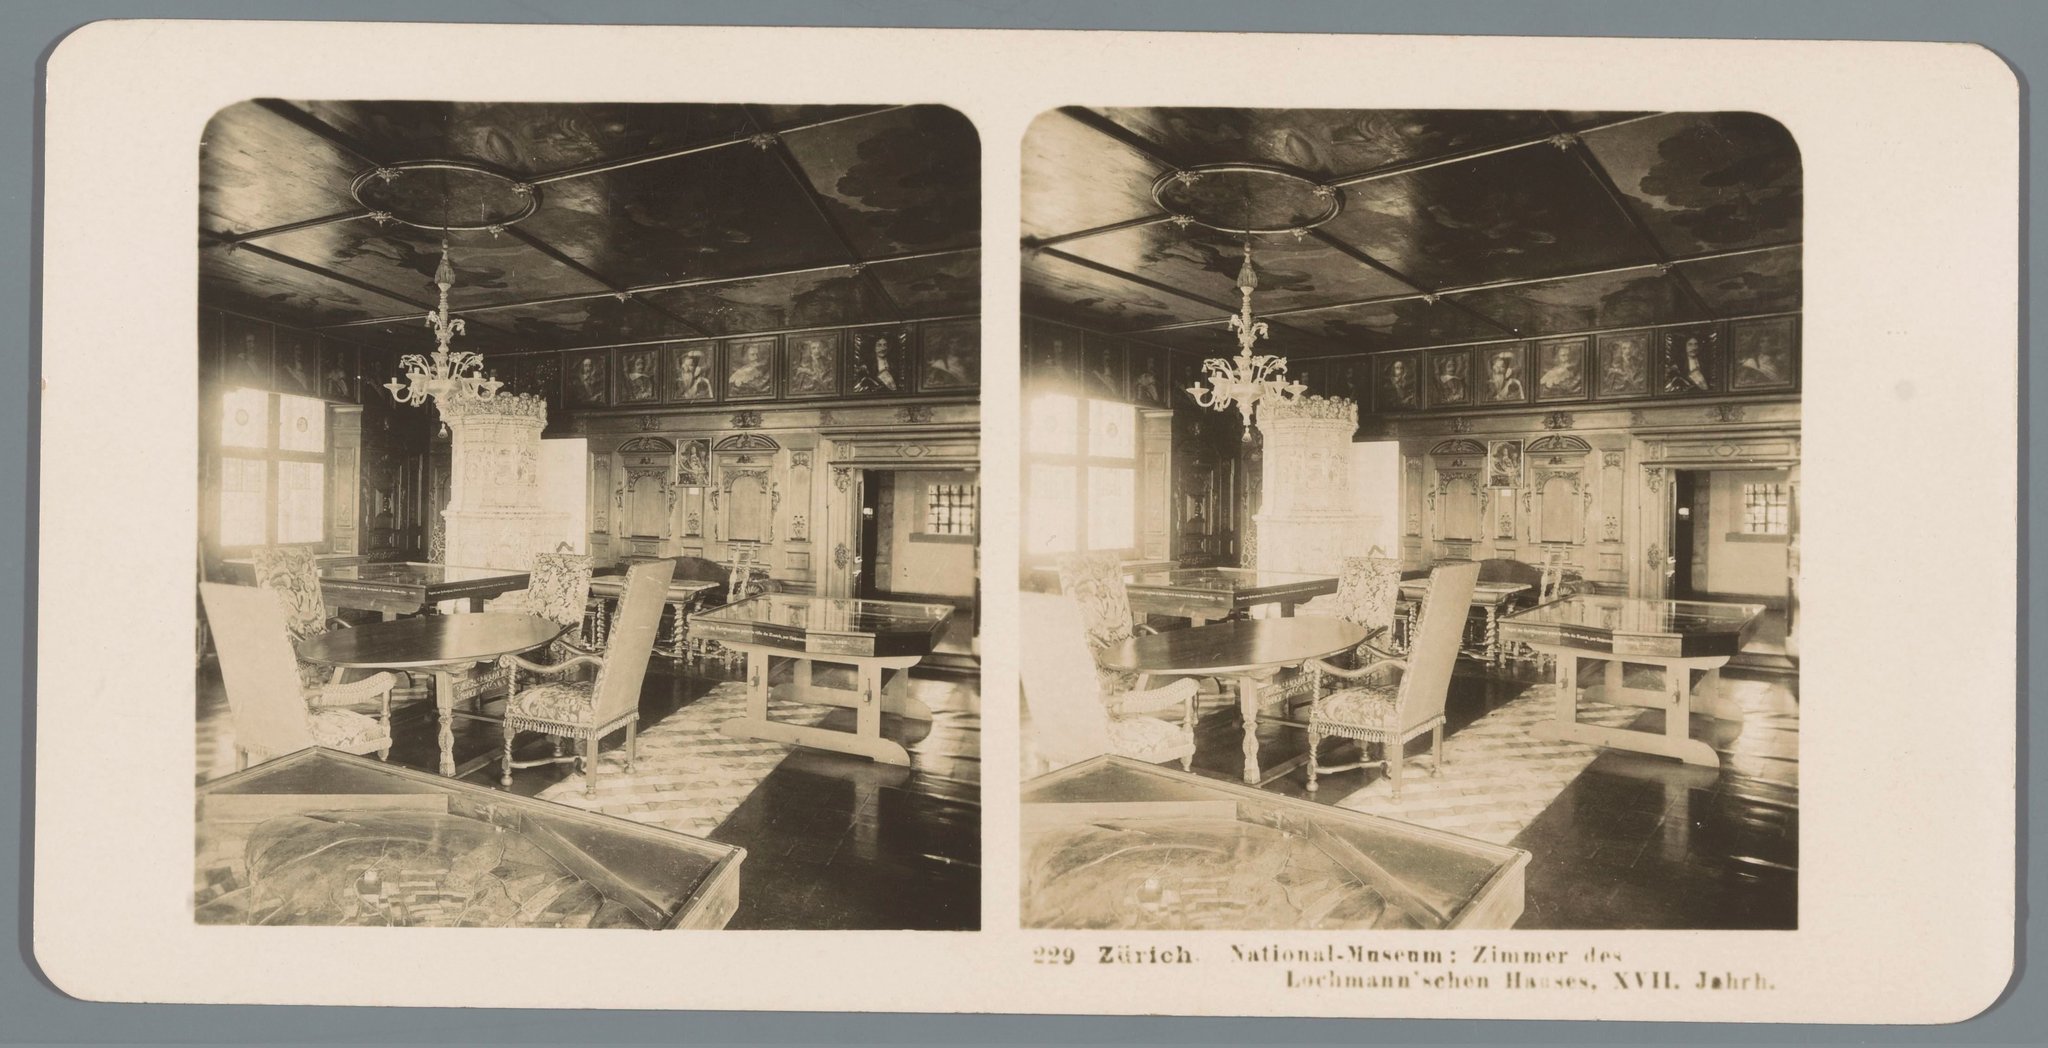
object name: stereograph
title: Zürich. National-Museum: zimmer des Lochmann'schen Hauses, XVII. Jahrhundert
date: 1906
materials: cardboard, photographic support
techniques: gelatin silver print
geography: landesmuseum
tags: permanent exhibition, museum, interior ~ representation of a building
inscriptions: inscription: ‘Neue Photographische Gesellschaft A. G., Steglitz-Berlin. 1906.’, number: ‘229’